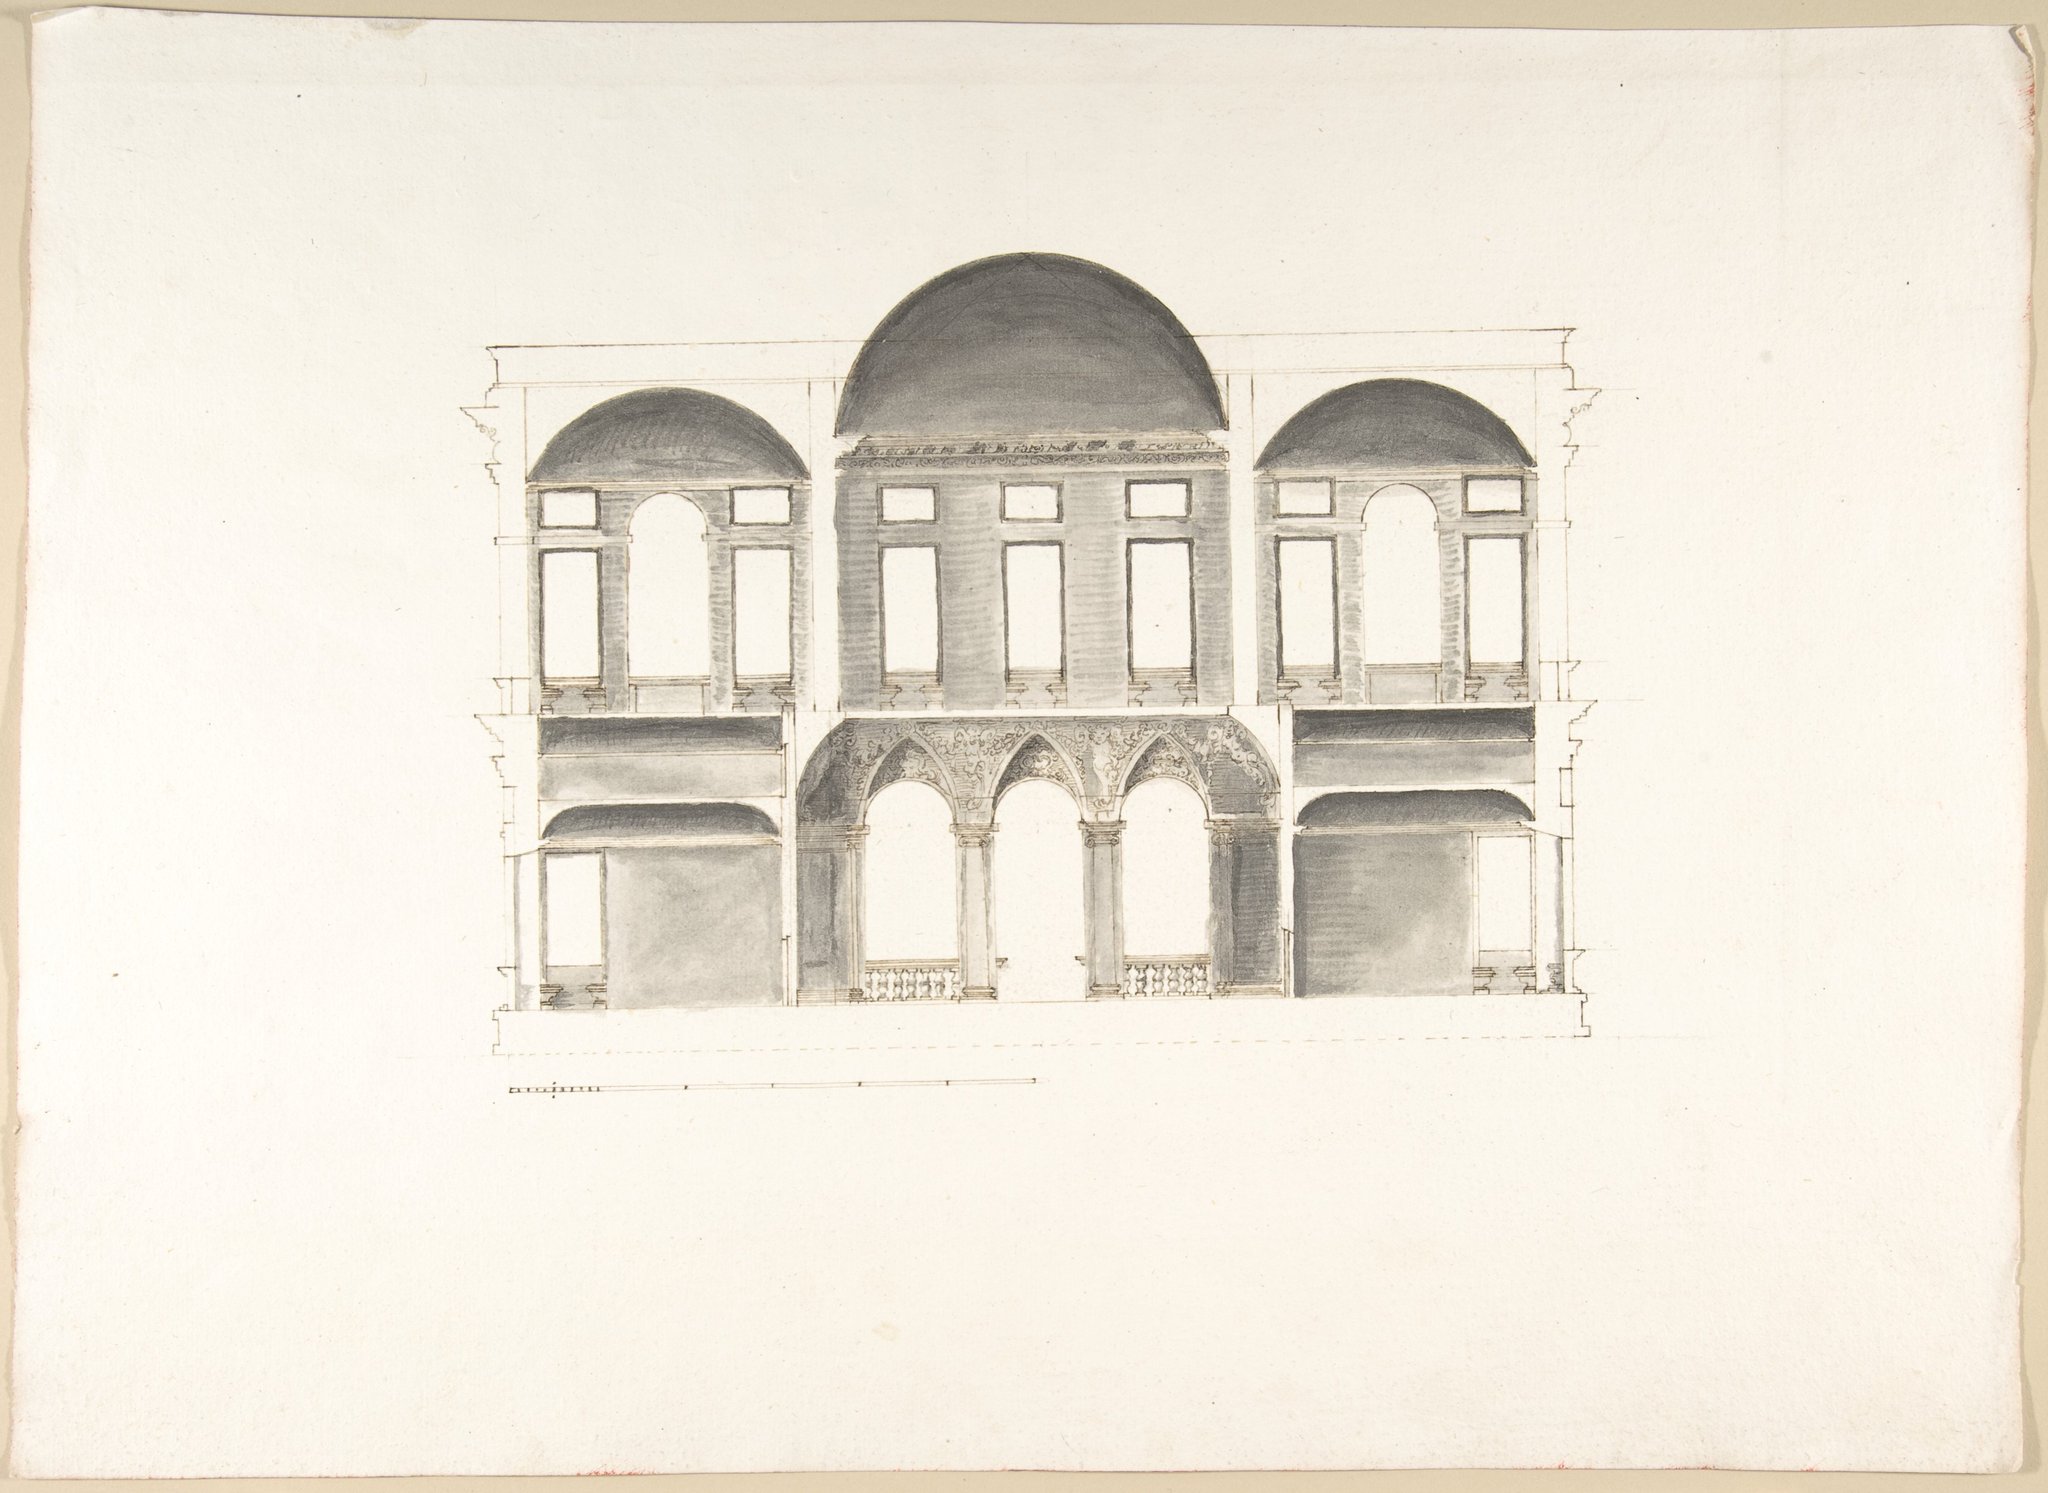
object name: drawing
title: Section of a Palace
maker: pietro paolo coccetti (cocchetti)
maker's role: artist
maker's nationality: italian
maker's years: 1710-1727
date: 1710-1727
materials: graphite, ink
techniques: brush, pen, wash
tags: architecture,arches,buildings,columns